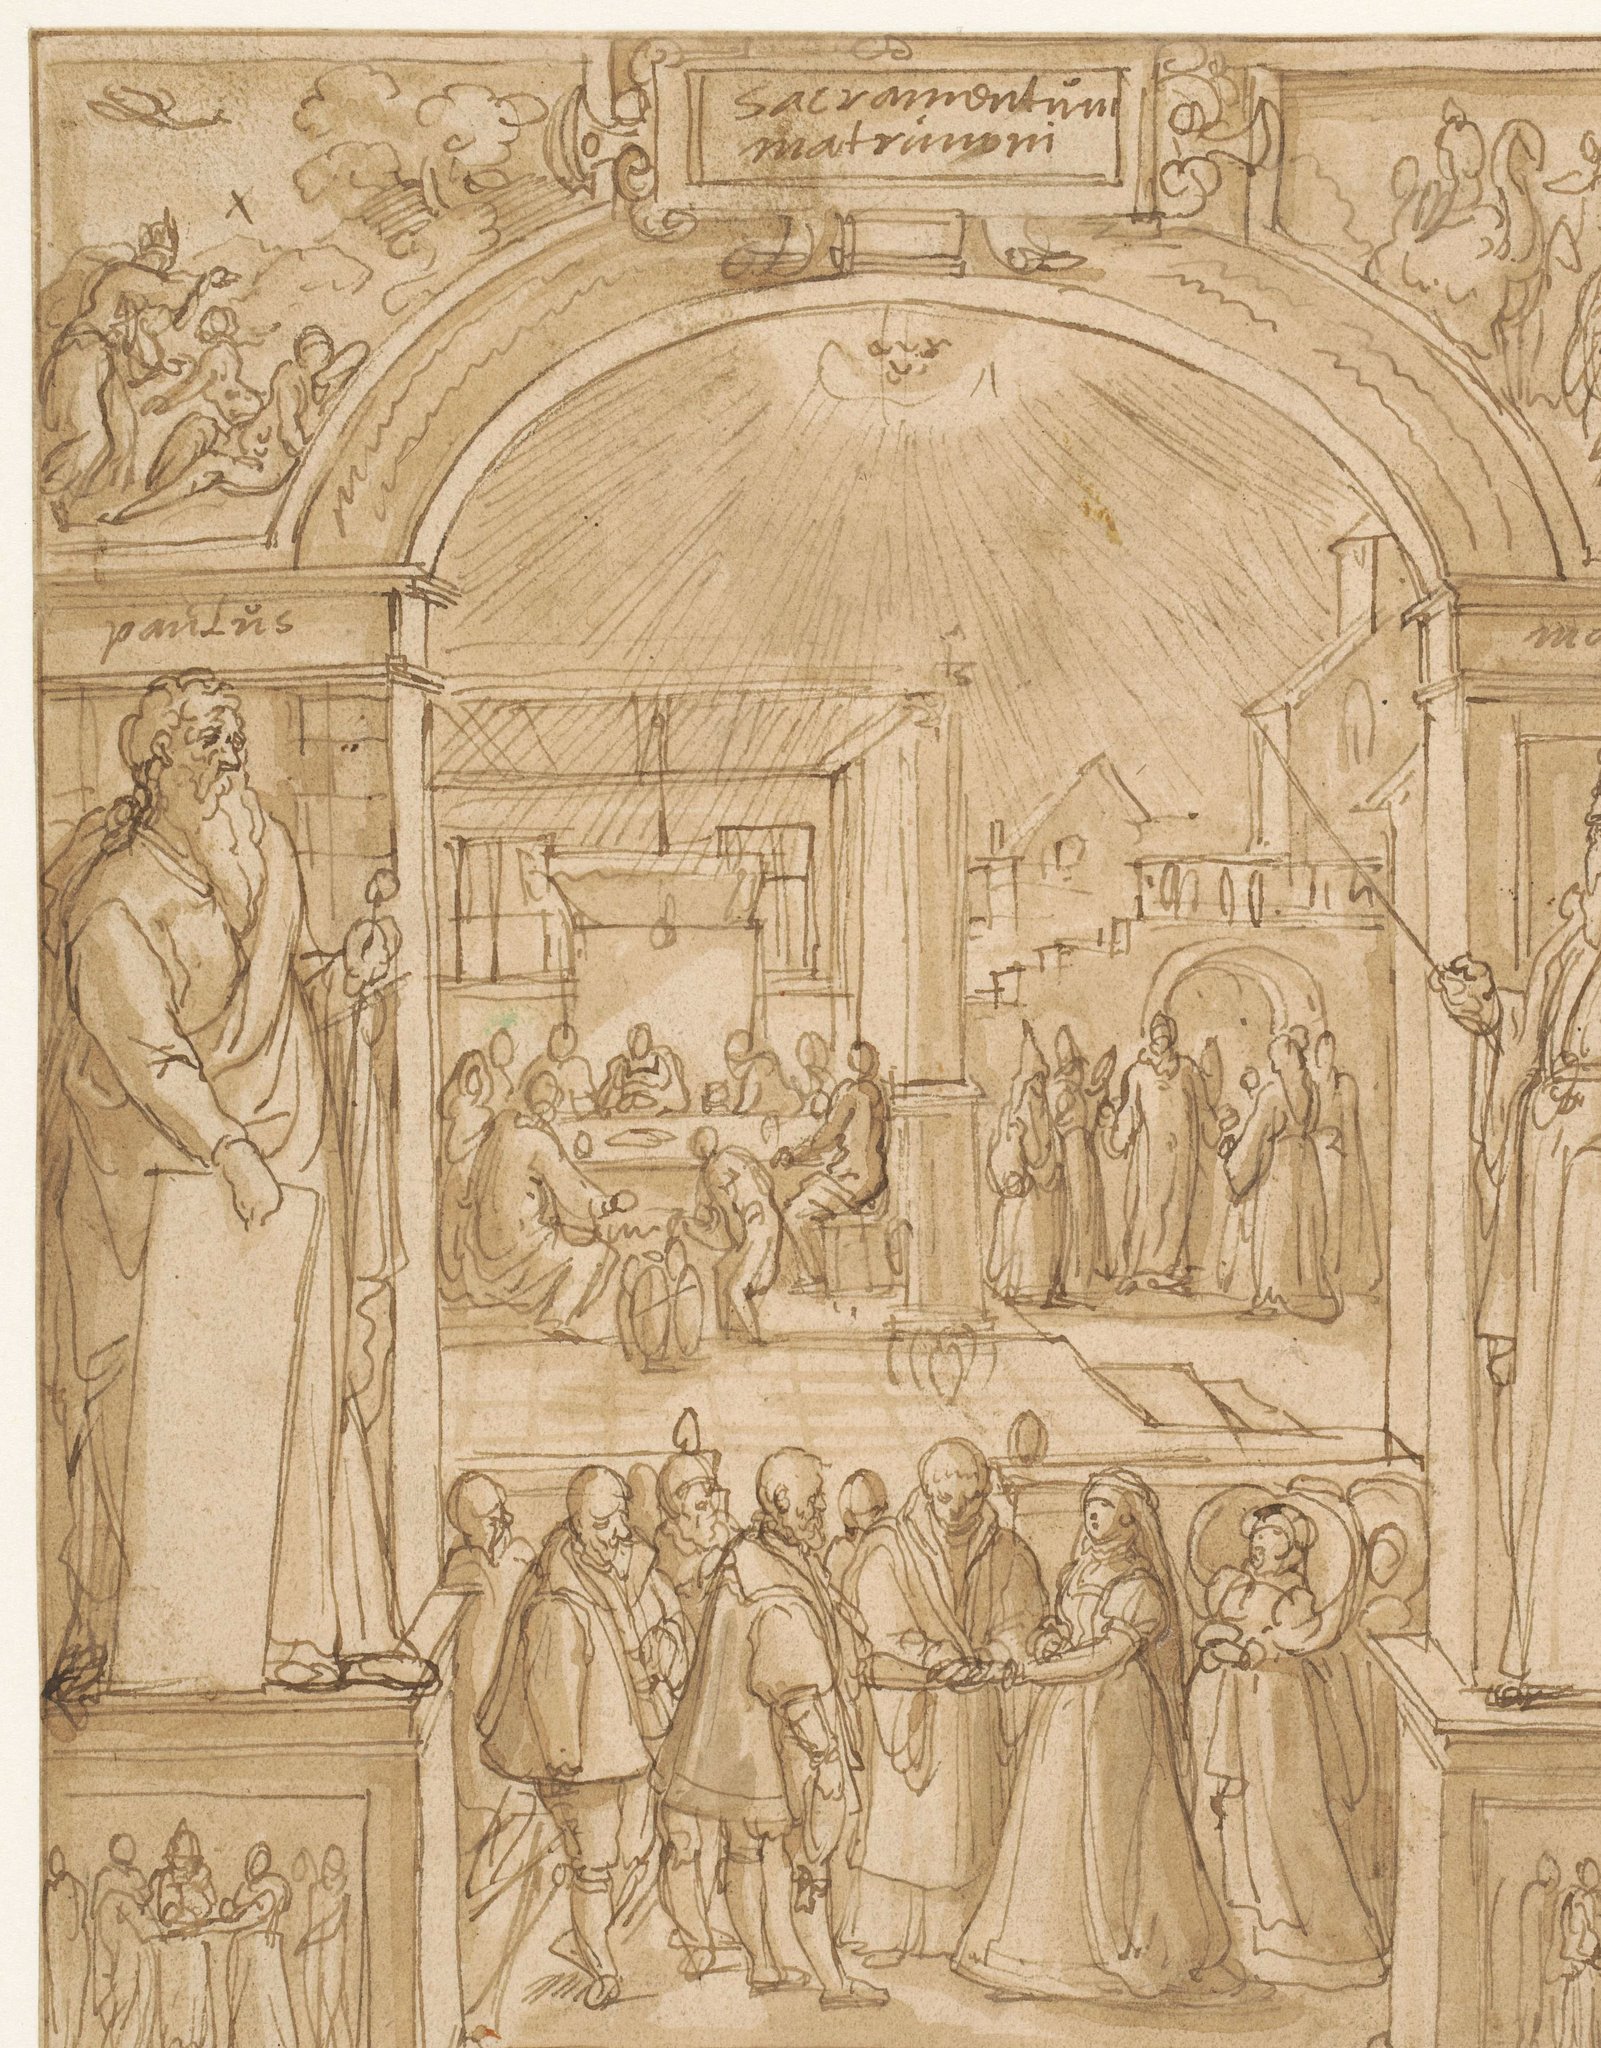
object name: drawing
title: Sacrament van het huwelijk, in omlijsting met Paulus en Mozes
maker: hans bol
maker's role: draughtsman, print maker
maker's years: 1534-1593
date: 1500-1599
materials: ink, paper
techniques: brush, pen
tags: blessing the married couple